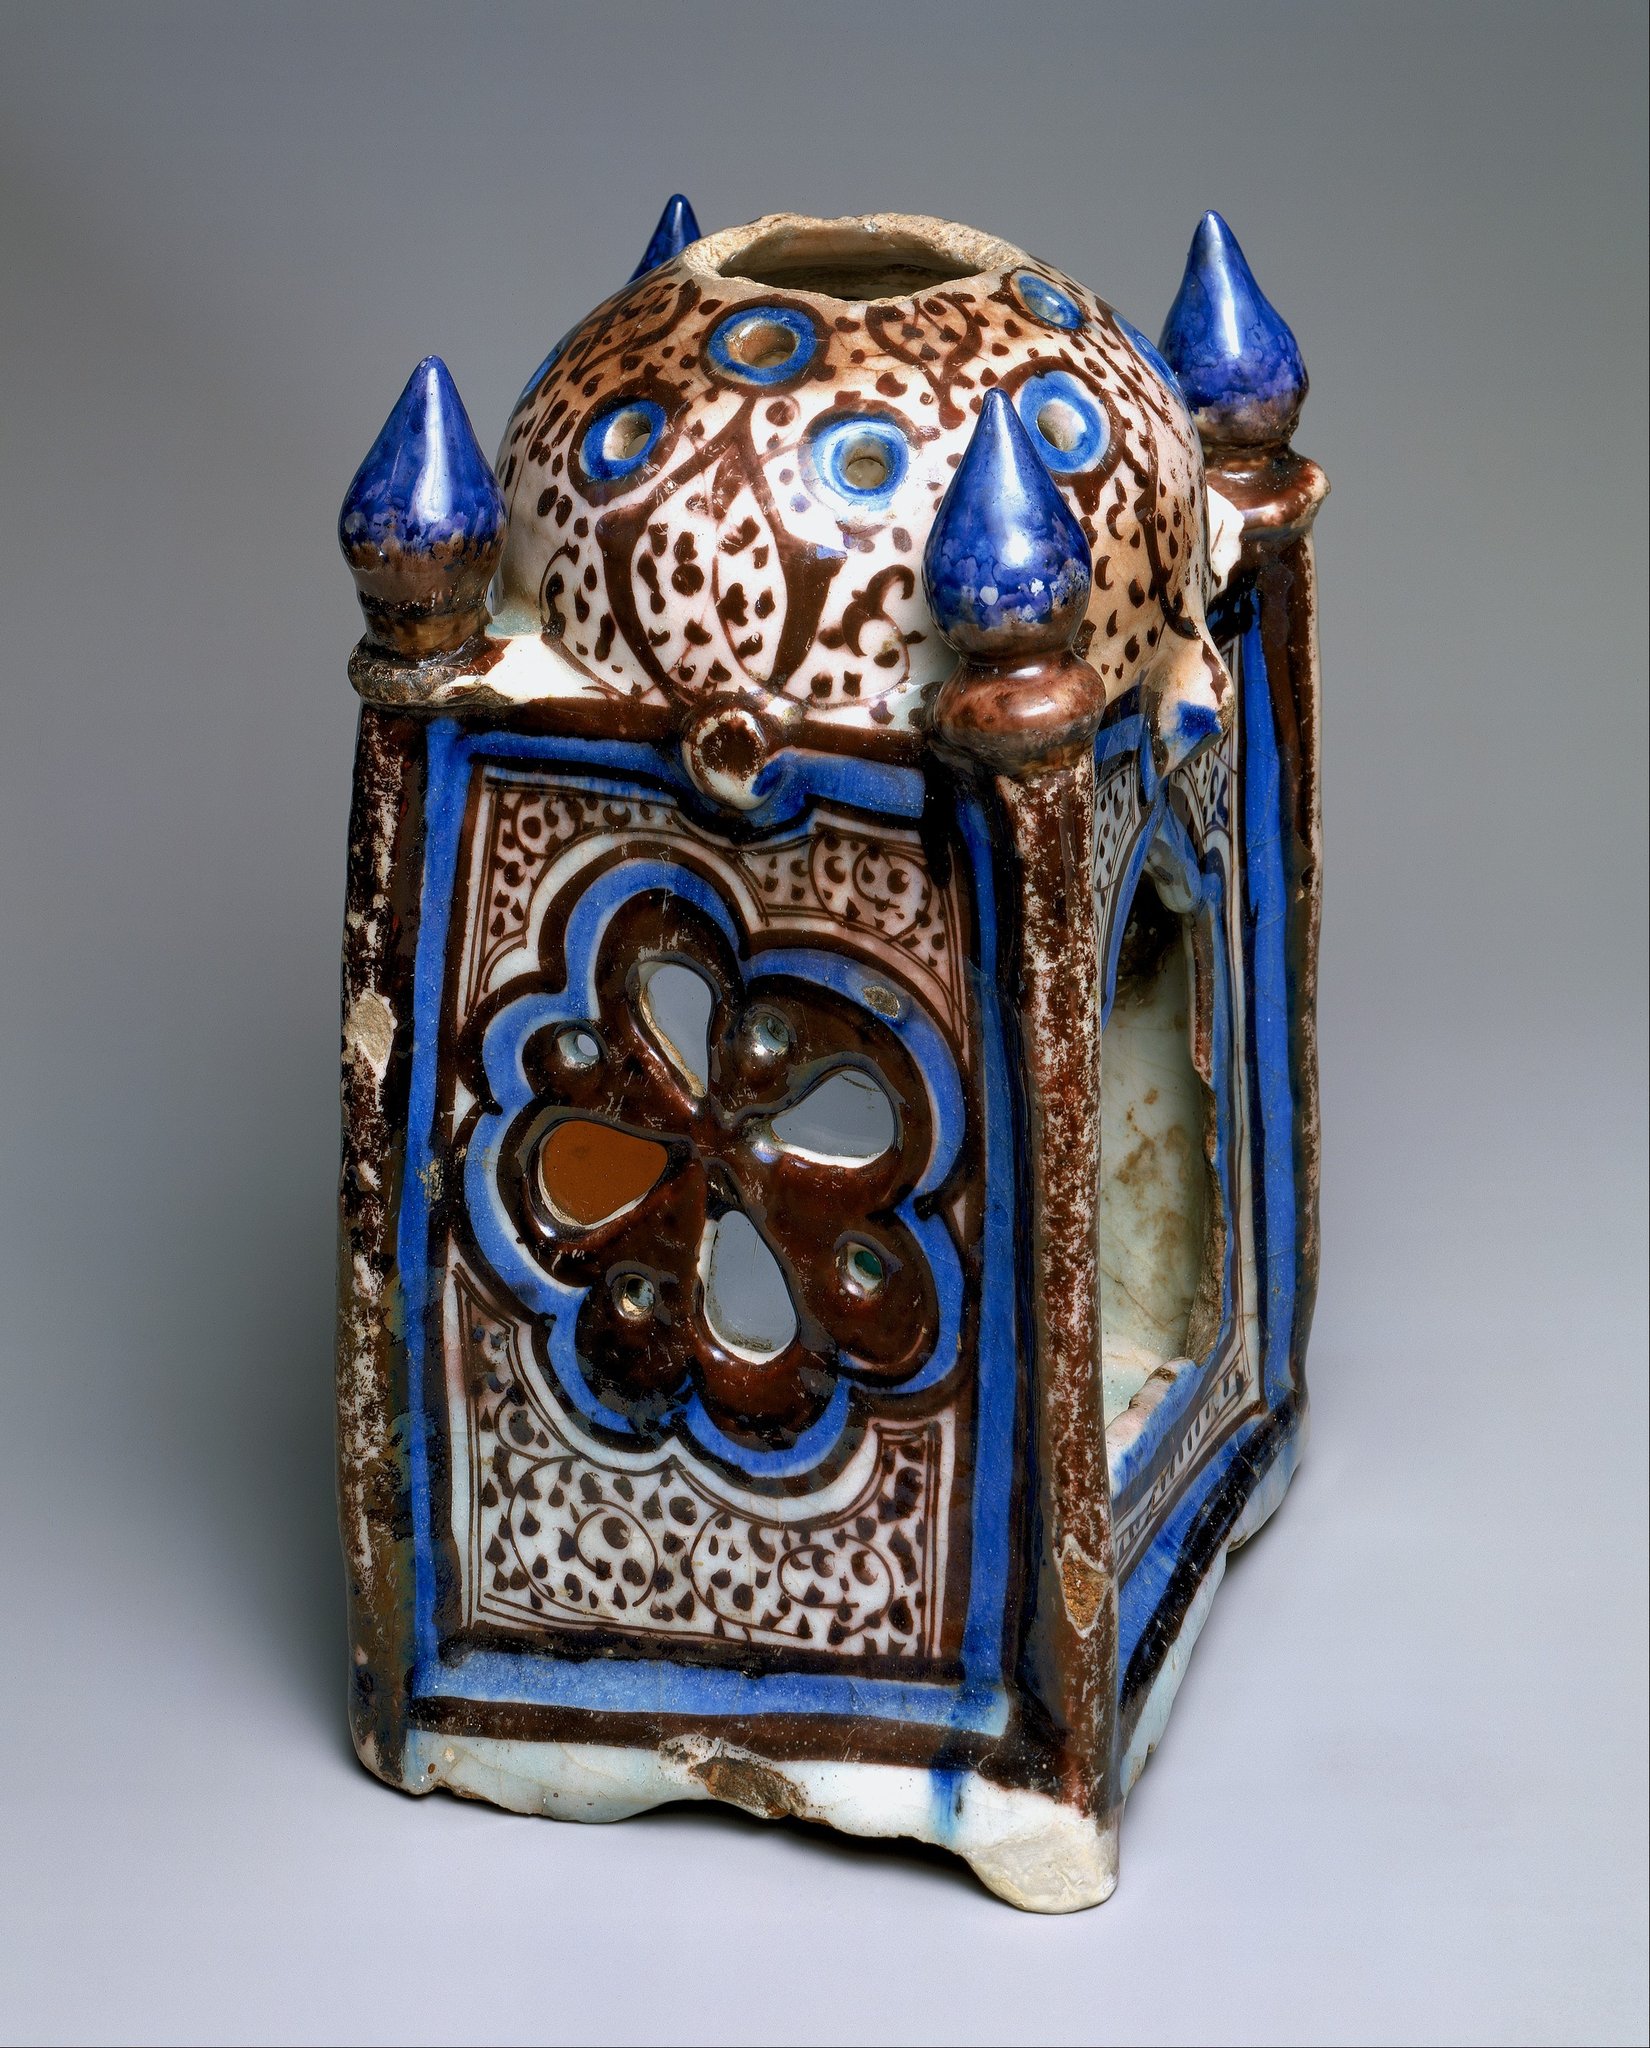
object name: lantern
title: Ceramic Lantern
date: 1201-1233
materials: glaze, stonepaste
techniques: luster painting, painting, underglaze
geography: syria